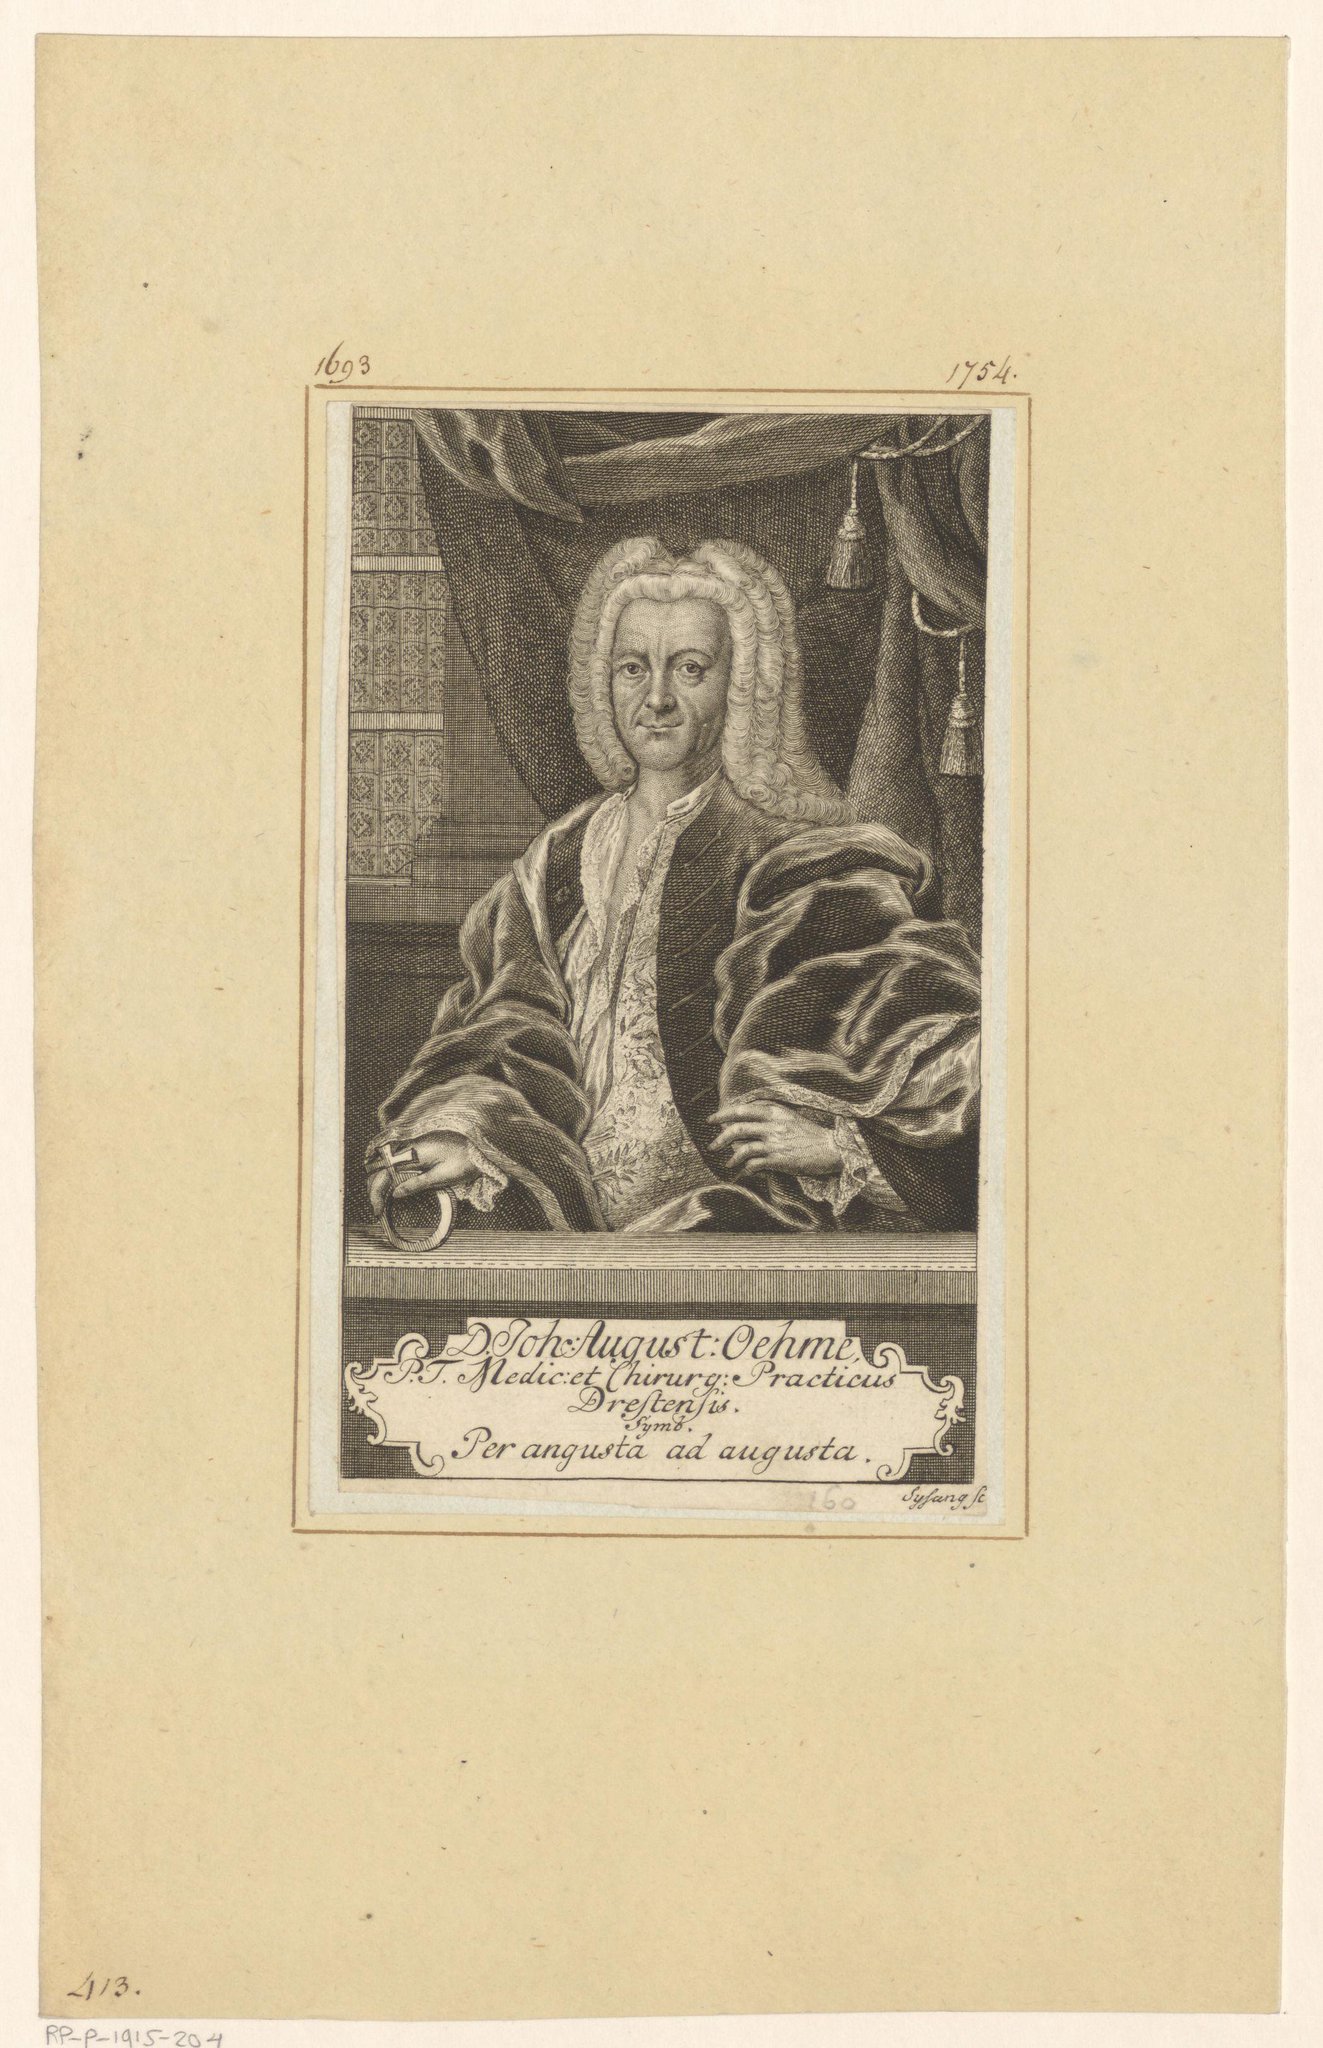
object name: print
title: Portret van Johann August Oehme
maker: johann christoph sysang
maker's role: print maker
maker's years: 1703-1757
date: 1730-1757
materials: paper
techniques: engraving, etching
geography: germany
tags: bookshelves, historical persons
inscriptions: collector's mark: Lugt 2228, number: ‘413’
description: De prent is gemonteerd op een opzetvel voorzien van een kader met pen in bruin en het geboorte- en sterfjaar van de geportretteerde.